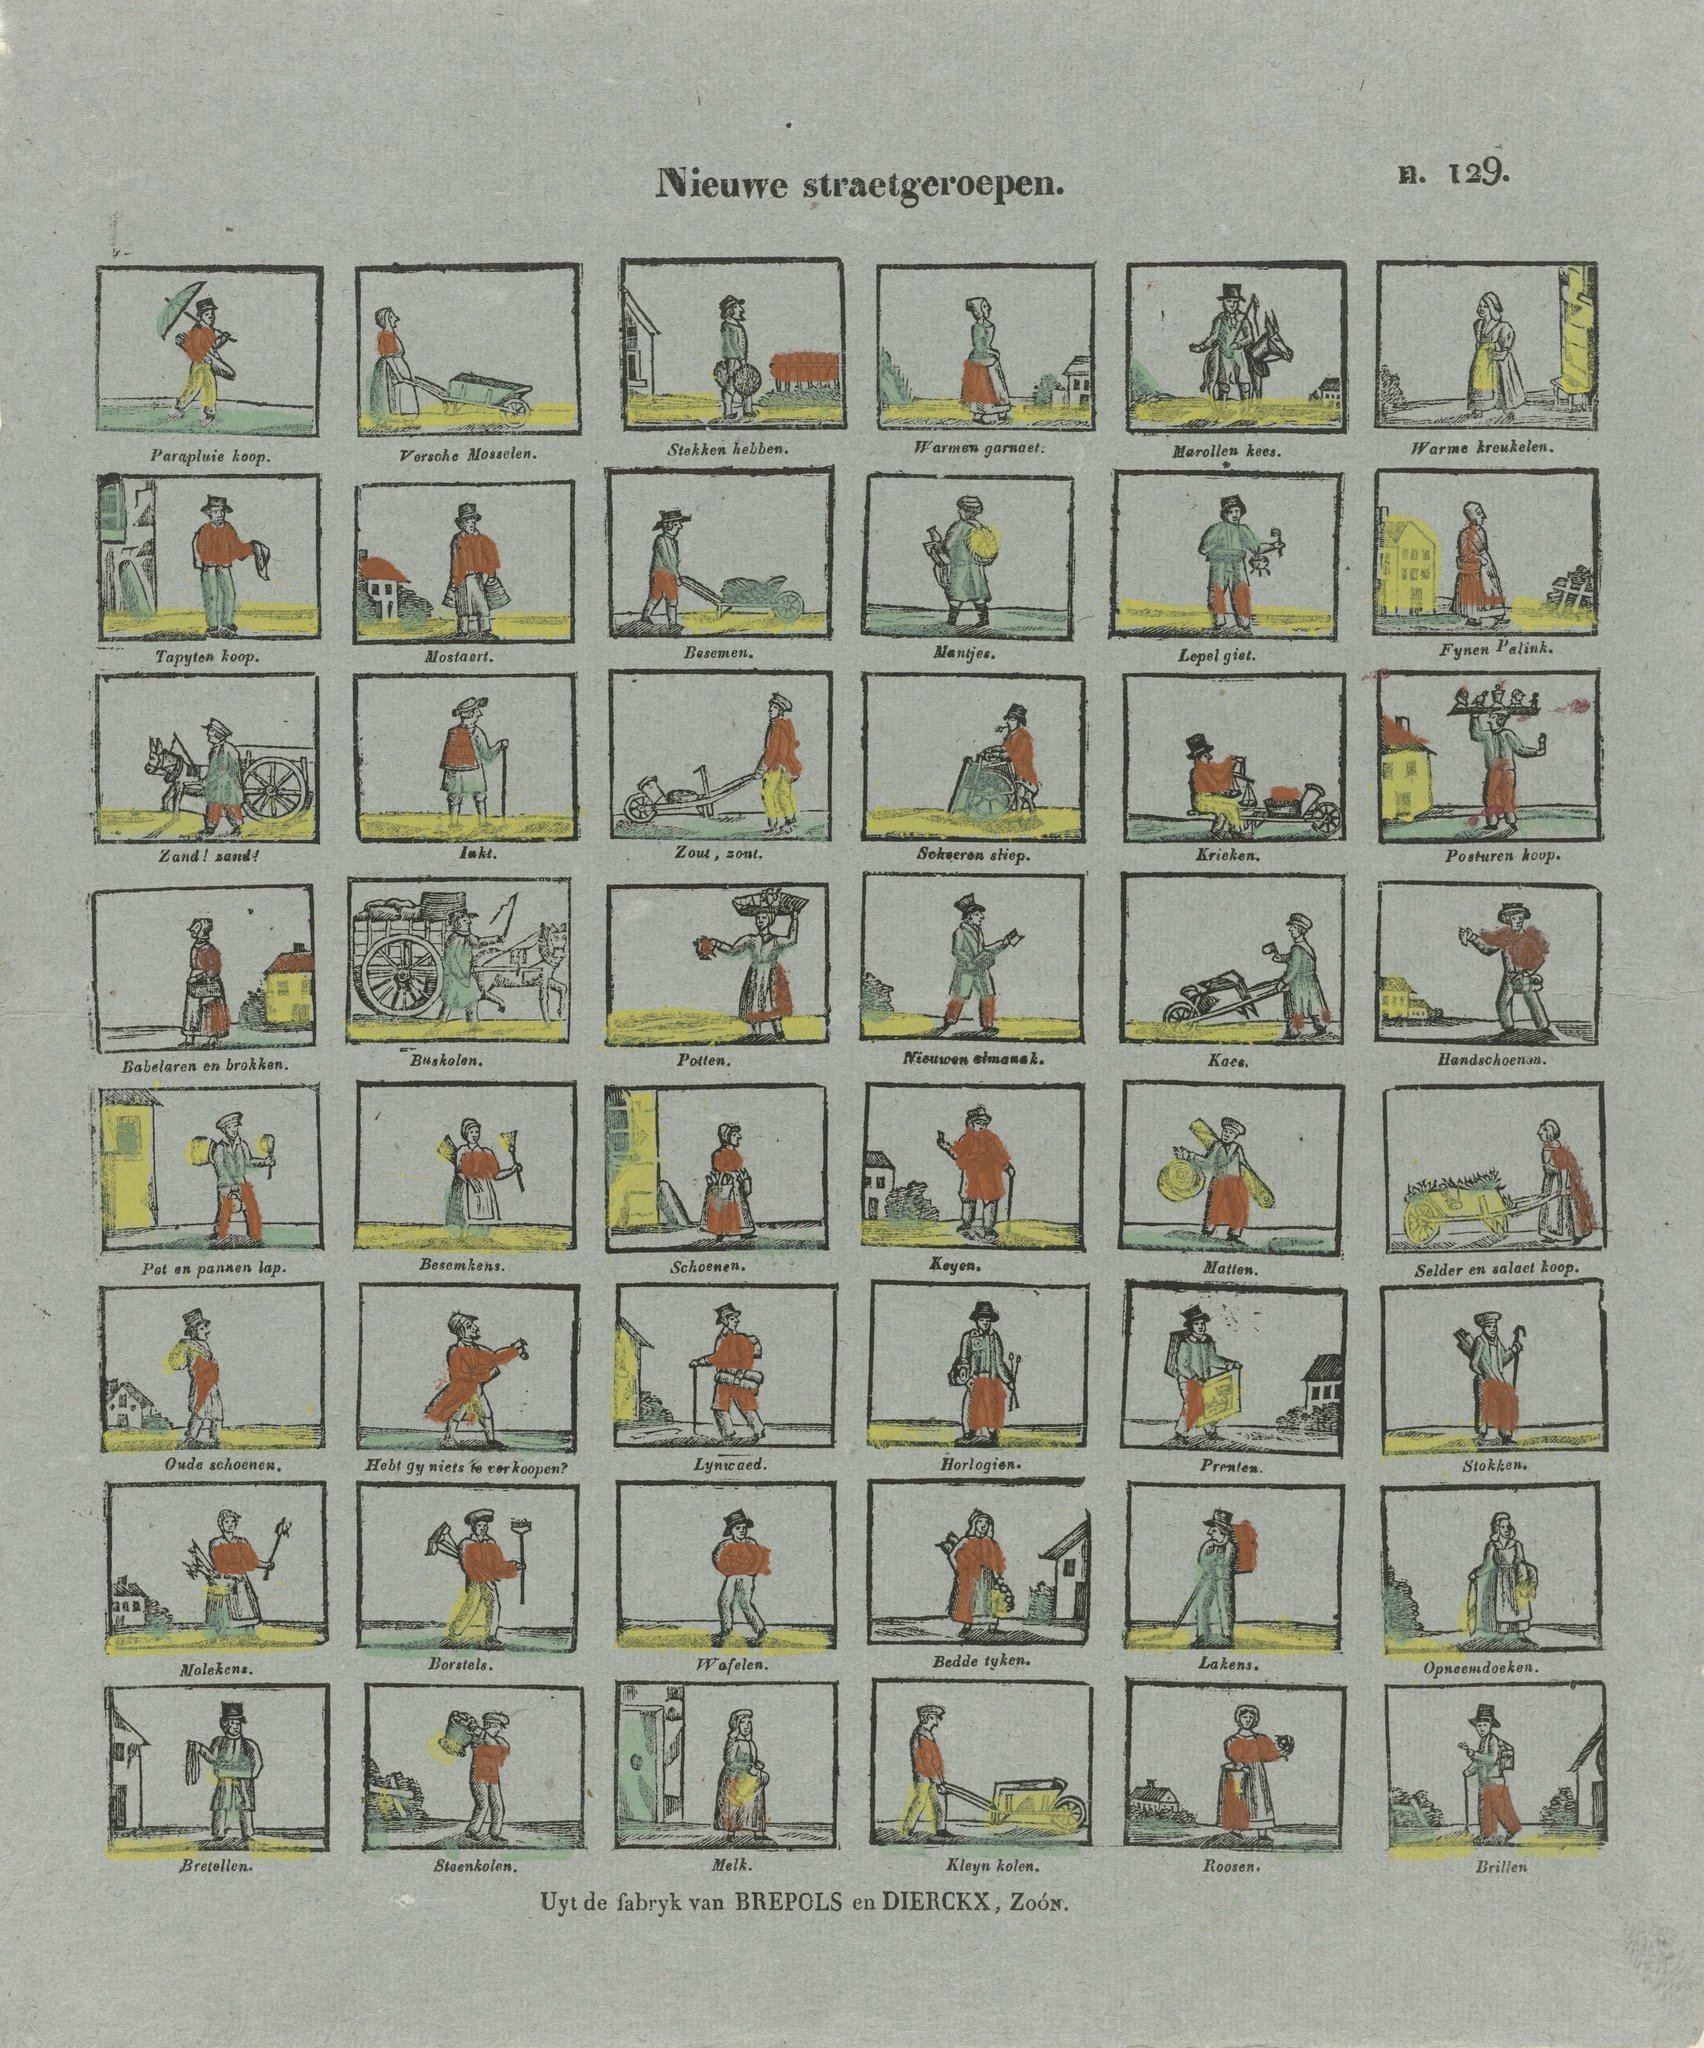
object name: popular print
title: Nieuwe straetgeroepen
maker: Anonymous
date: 1833-1911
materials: paper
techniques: colour, letterpress printing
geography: turnhout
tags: street-trader, merchant, salesman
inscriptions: collector's mark: Lugt 2760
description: Blad met 48 voorstellingen van straatverkopers. Onder elke afbeelding een onderschrift in het Nederlands. Genummerd rechtsboven: n. 129.